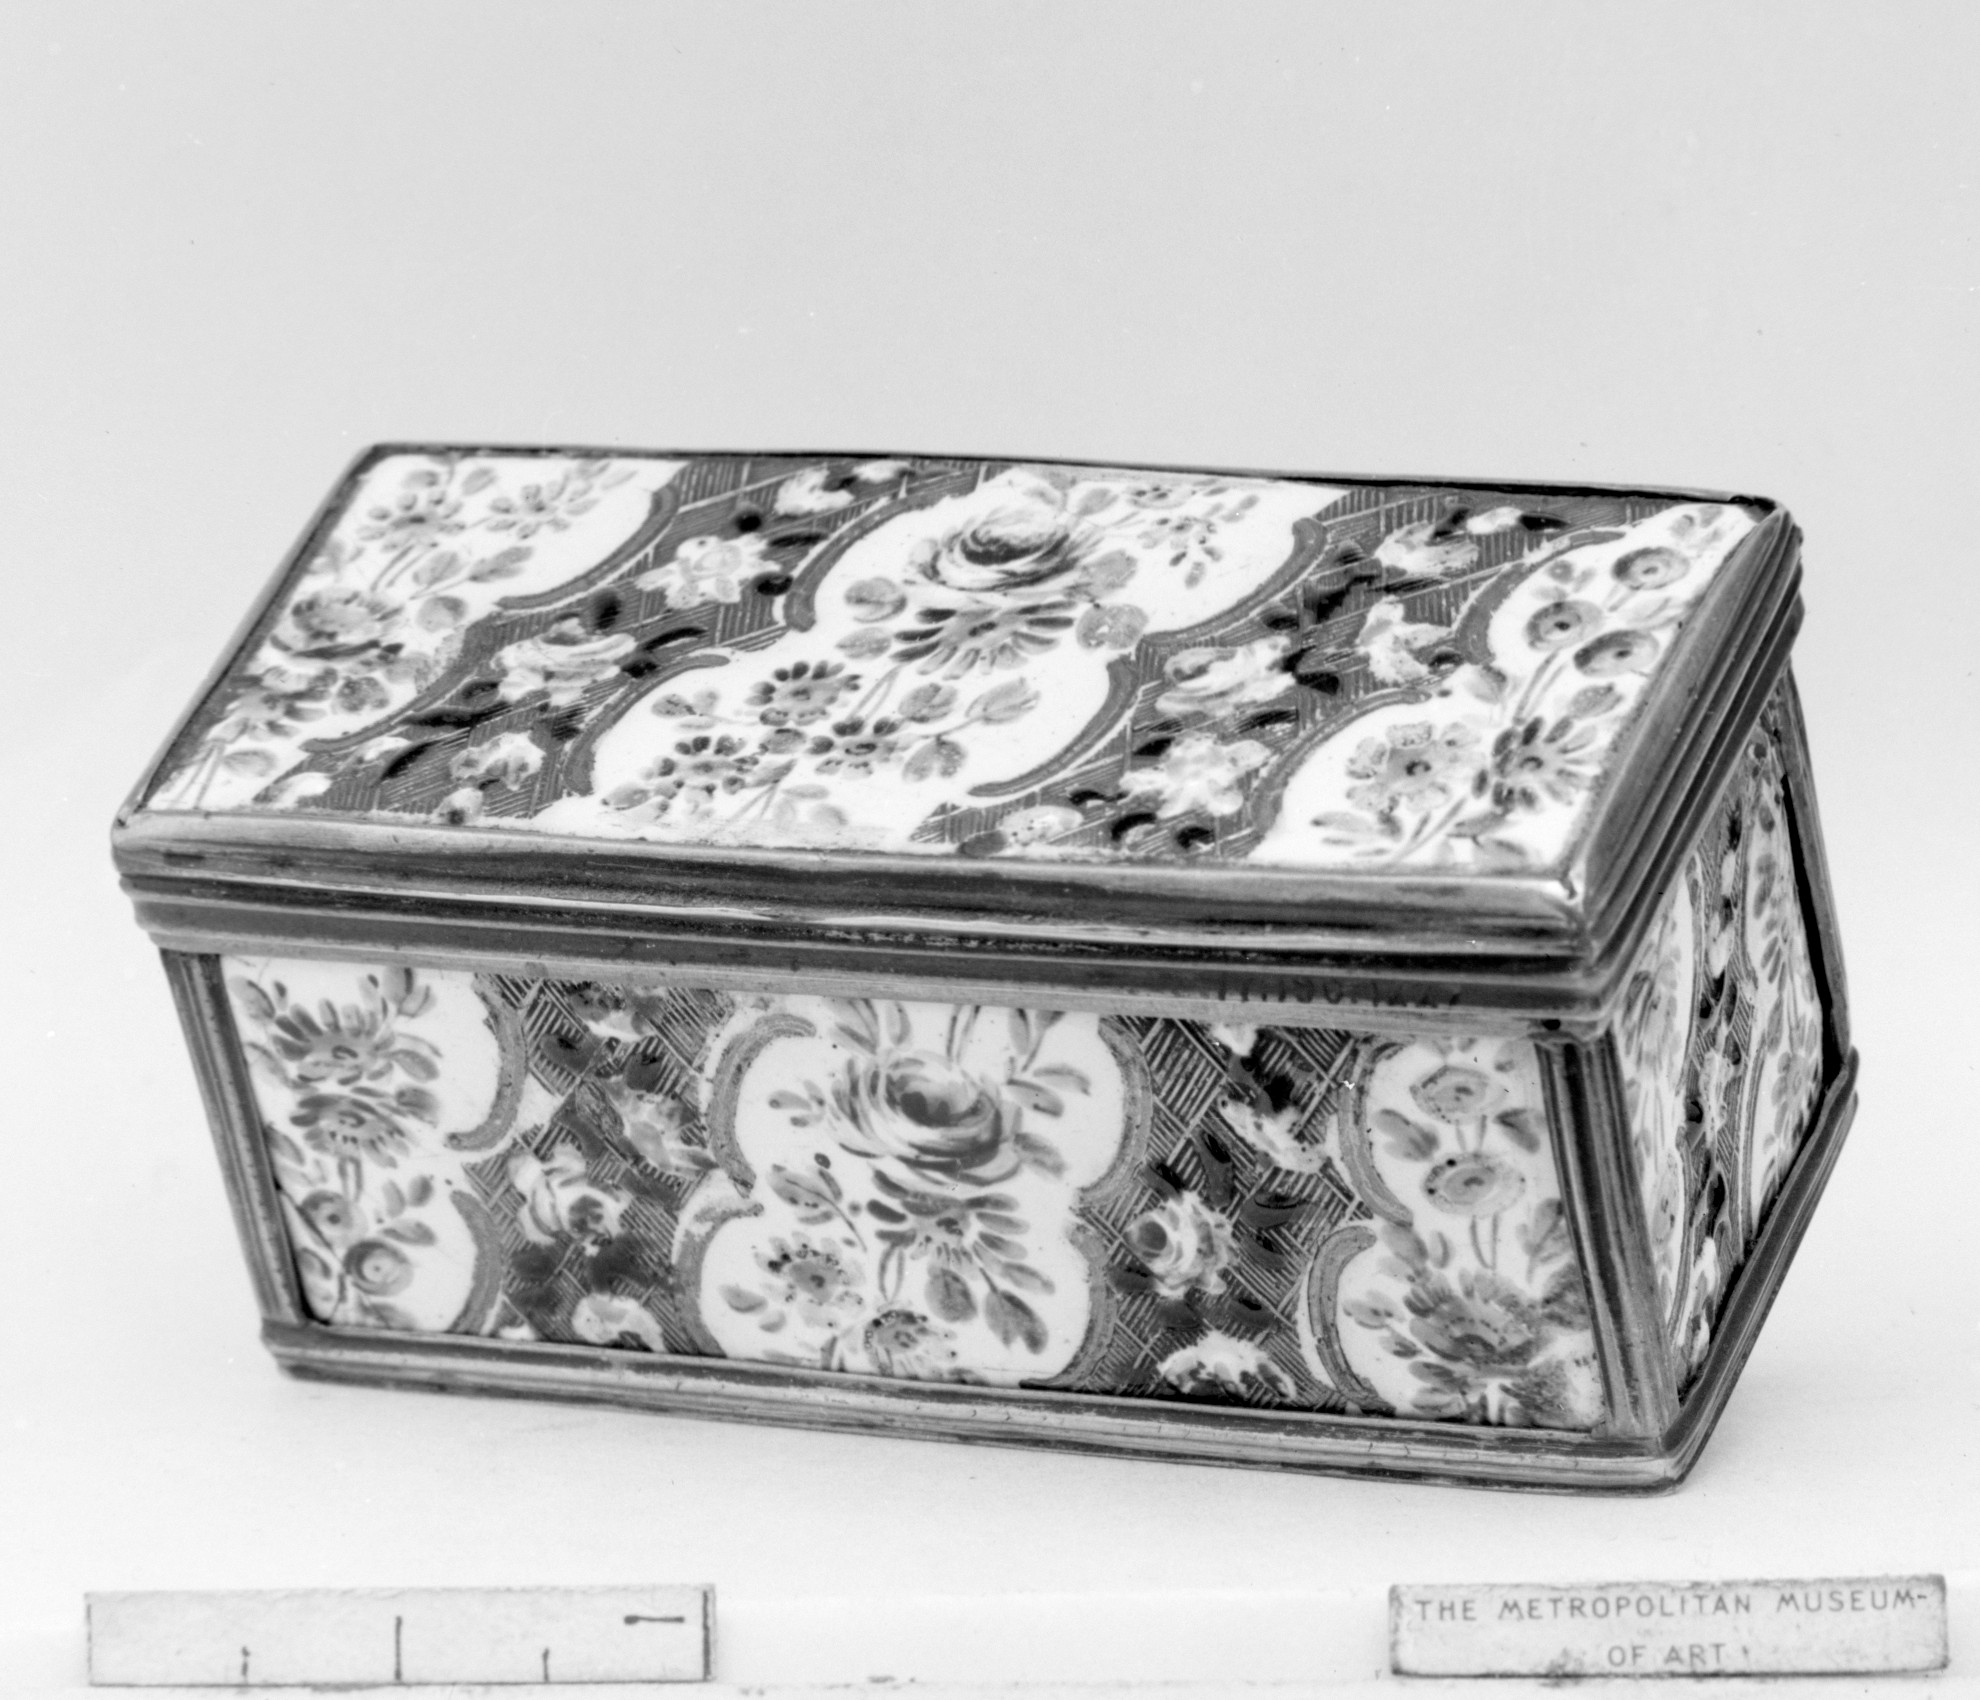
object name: snuffbox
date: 1801-1900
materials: enamel, silver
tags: flowers